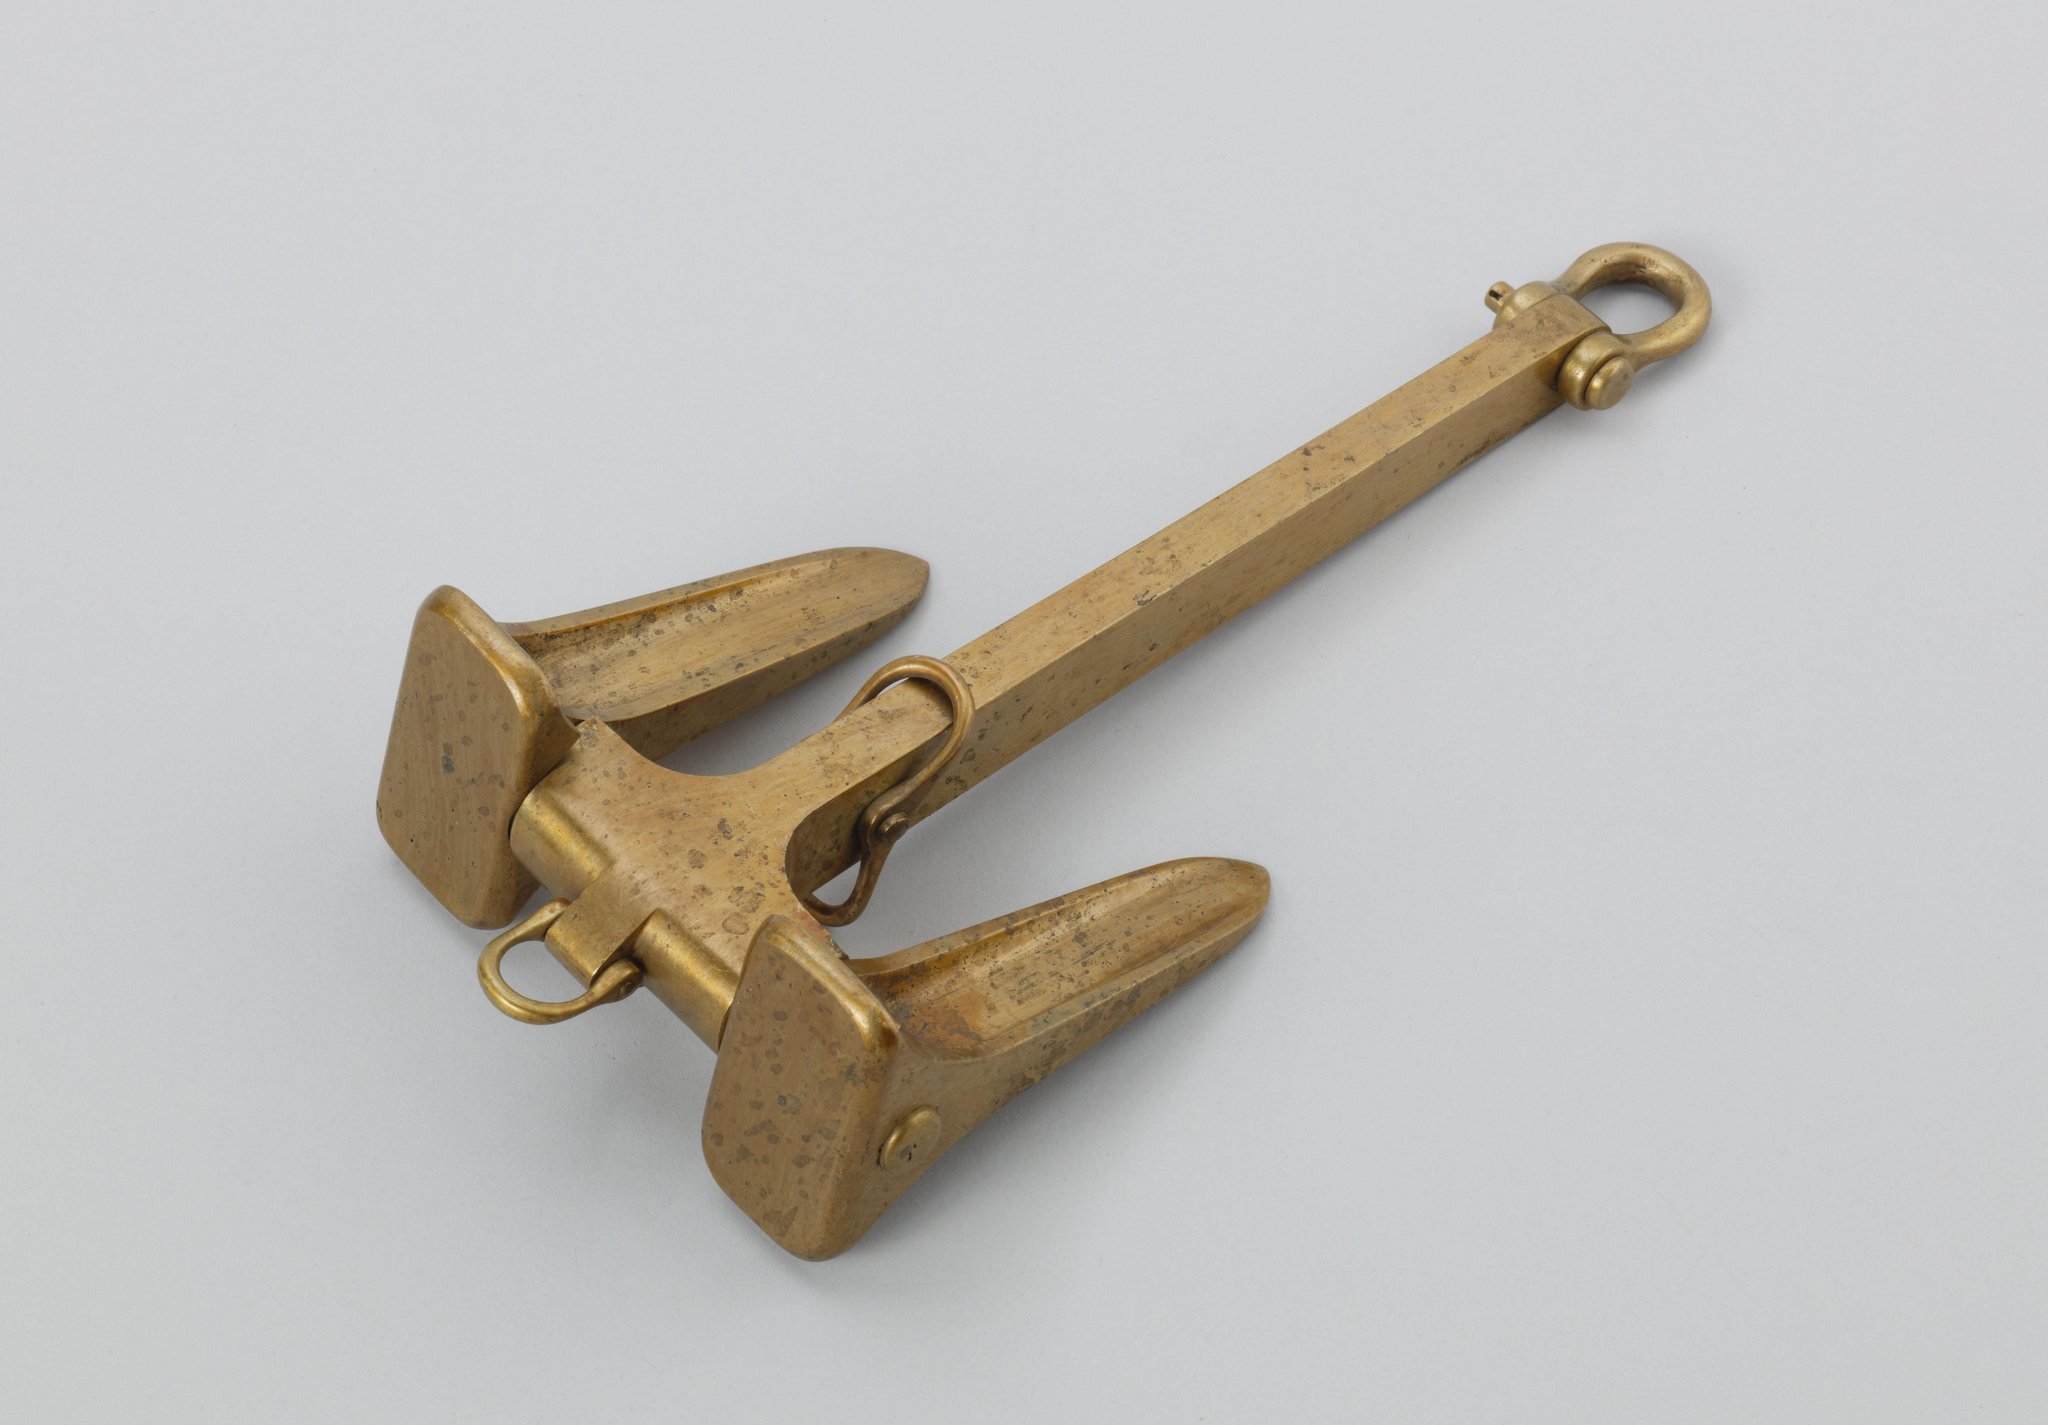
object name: instruction model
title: Model of an Anchor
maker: Anonymous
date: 1879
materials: brass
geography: netherlands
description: Model van een 'plattehands-'anker zonder ankerstok. Beide handen zijn parallel aan elkaar gemonteerd op een as, die door het ankerkruis loopt en waarop zij draaien. De platte voorkant van de handen doet het werk van de ankerstok en dwingt de punten van de handen naar beneden. Het model heeft een harp aan het eind van de schacht en een bij het kruis, en een dubbele schalm om de schacht heen. Schaal 1:10 (schatting).